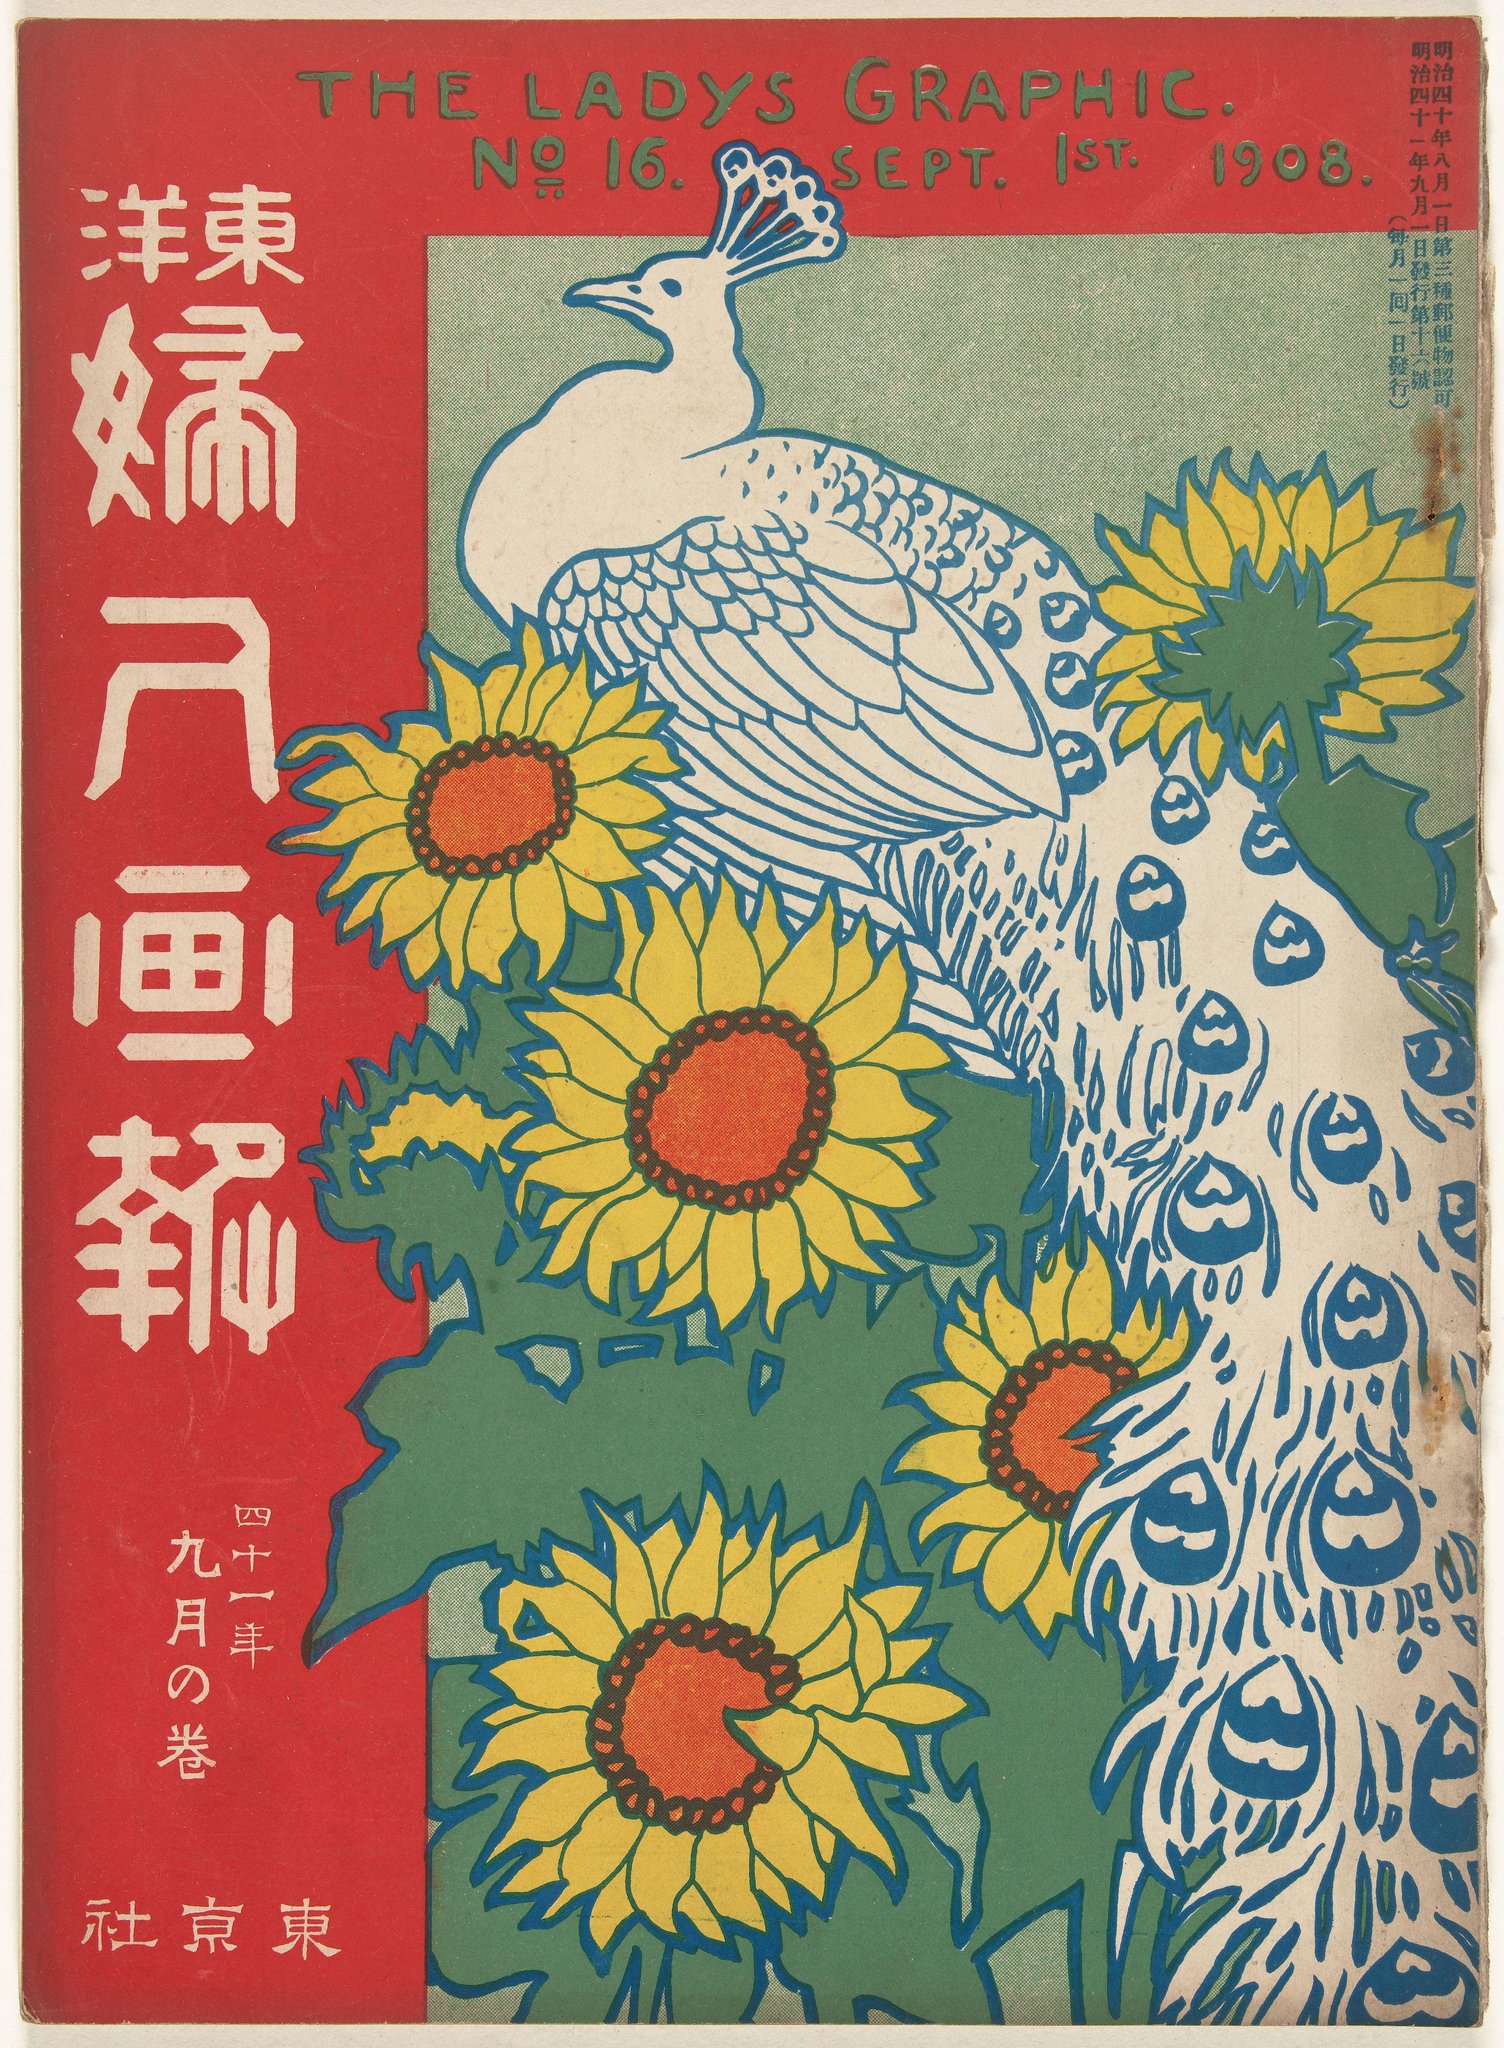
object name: magazine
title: Toyo Fujin gaho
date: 1908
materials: paper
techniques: letterpress printing, lithograph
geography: japan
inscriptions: date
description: Nummer 16 (1908) van het tijdschrift Toyo Fujin gaho: rode kaft waarop pauw tussen zonnebloemen; binnenin: frontispies waarop vrouw op veranda.